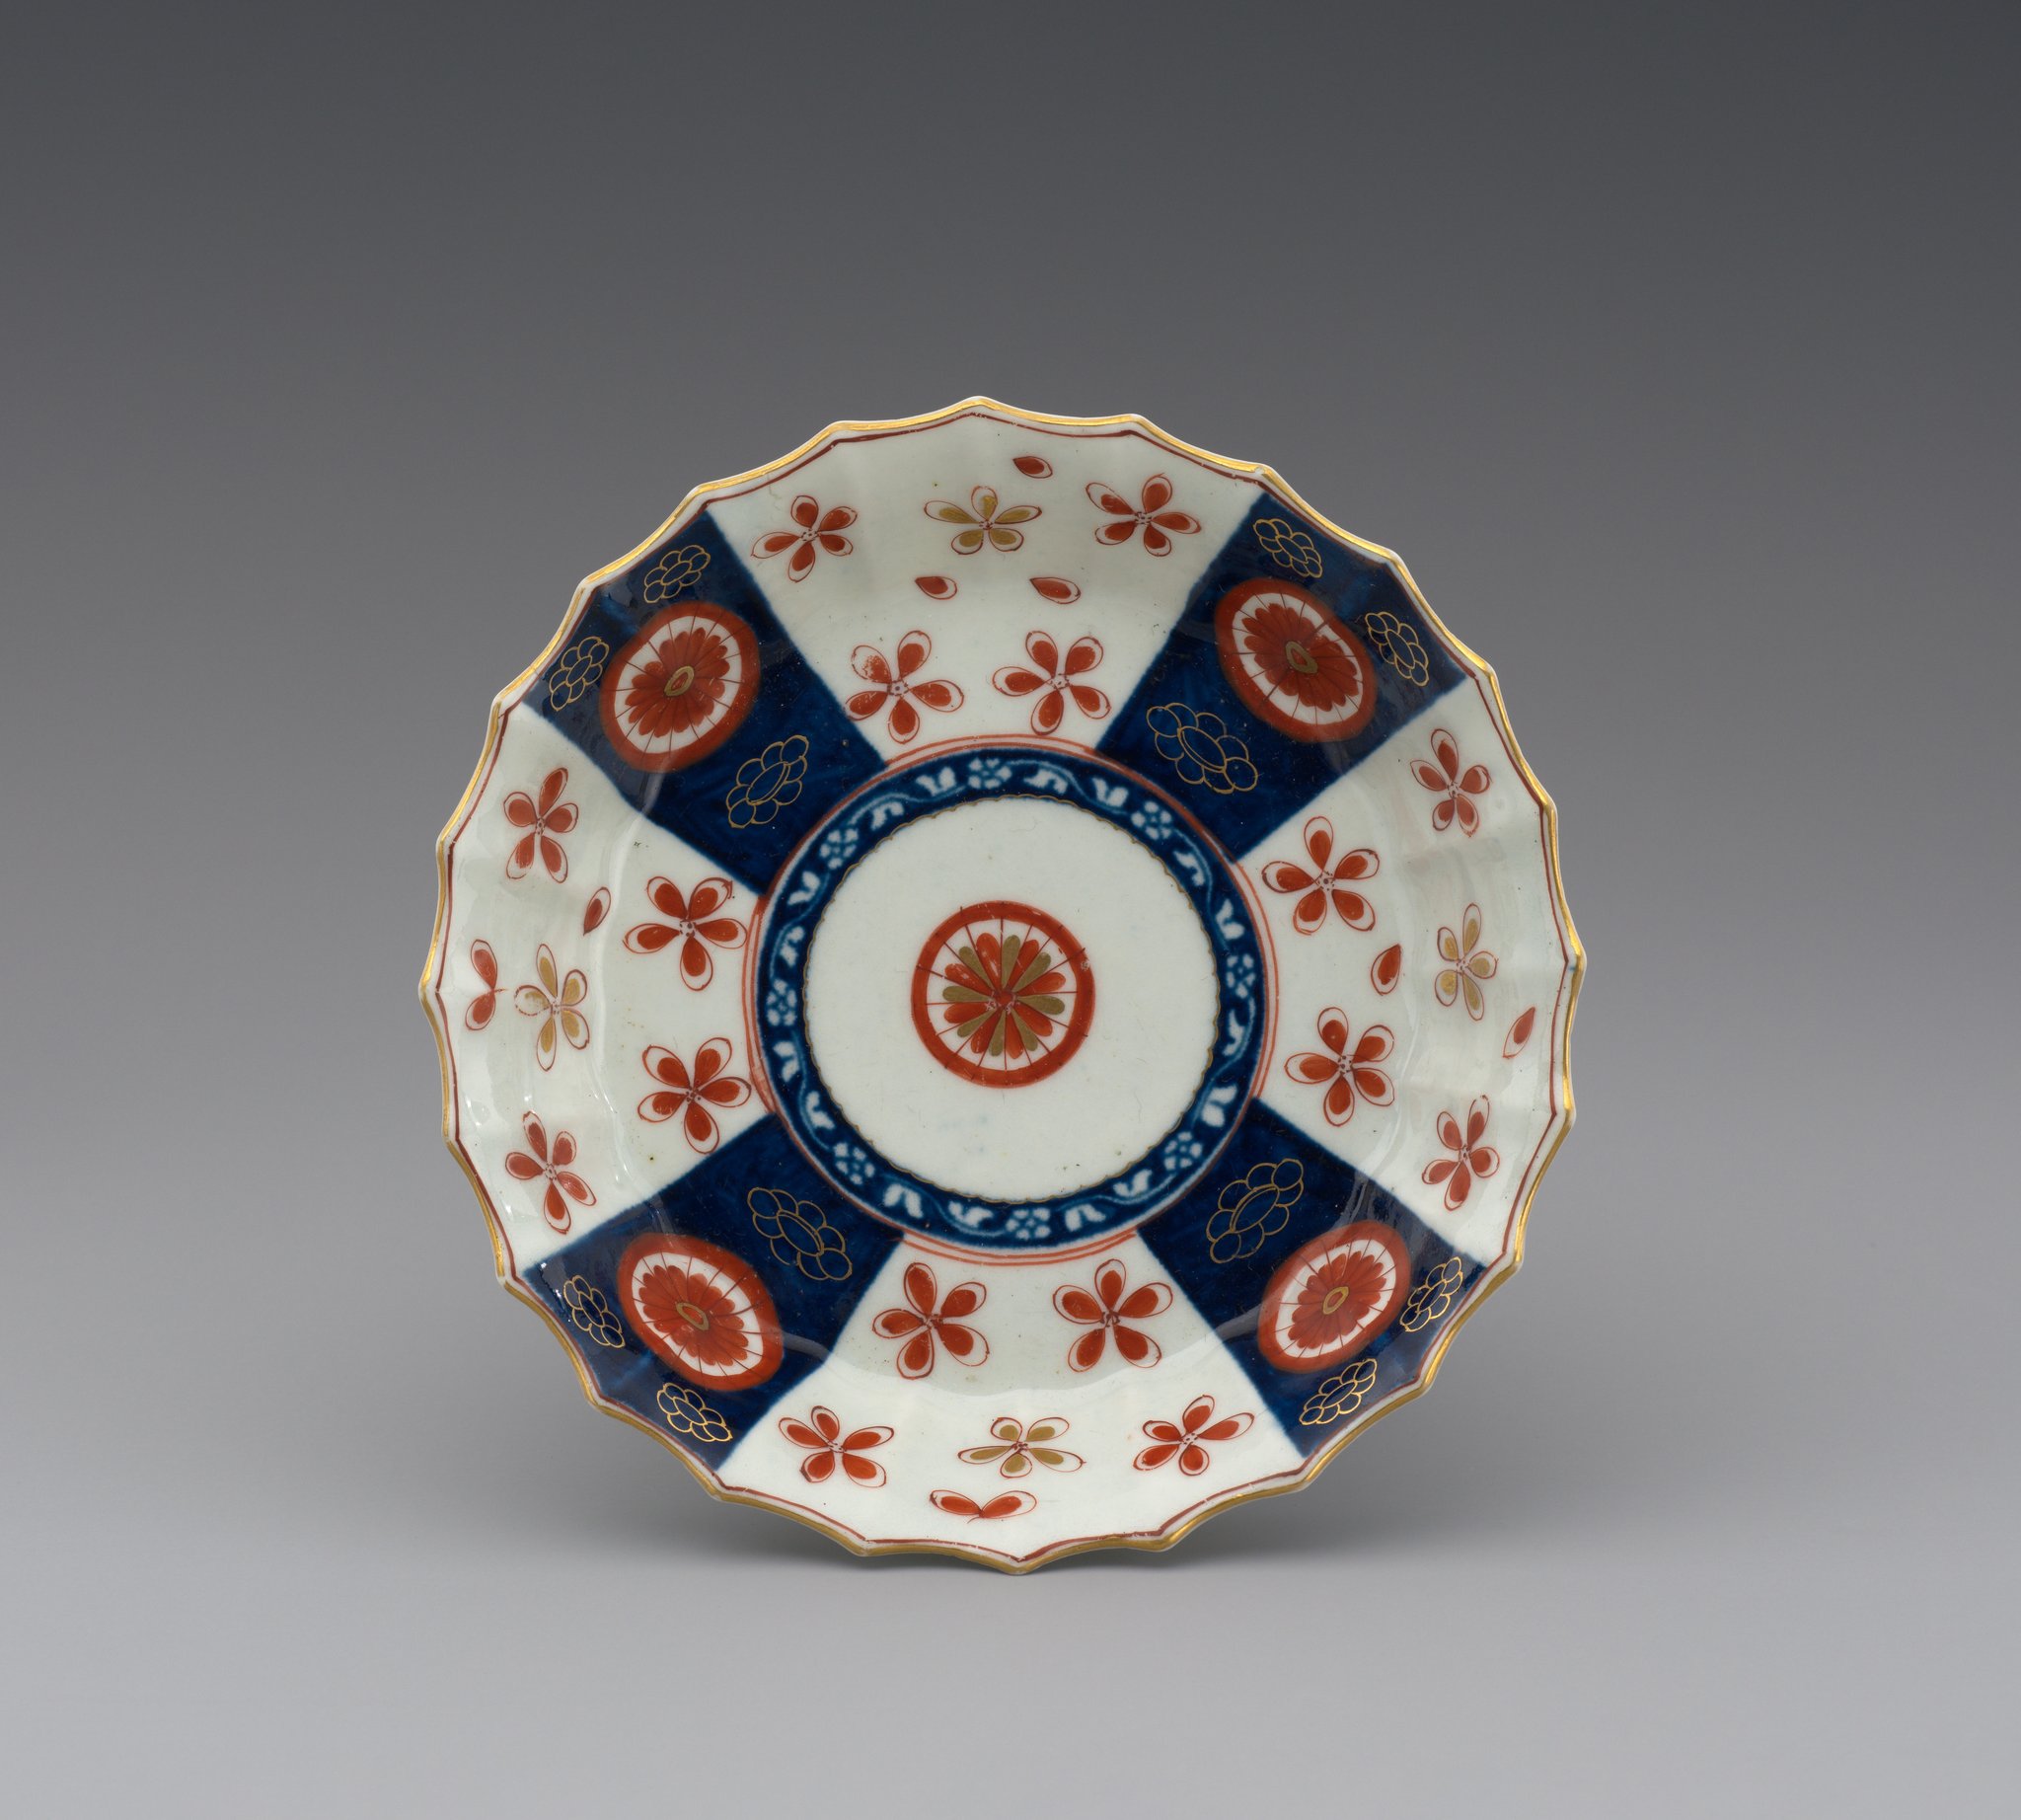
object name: saucer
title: Saucer (part of a service)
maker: worcester factory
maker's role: factory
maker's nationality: british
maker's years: 1751-2008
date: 1765-1775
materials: soft paste porcelain